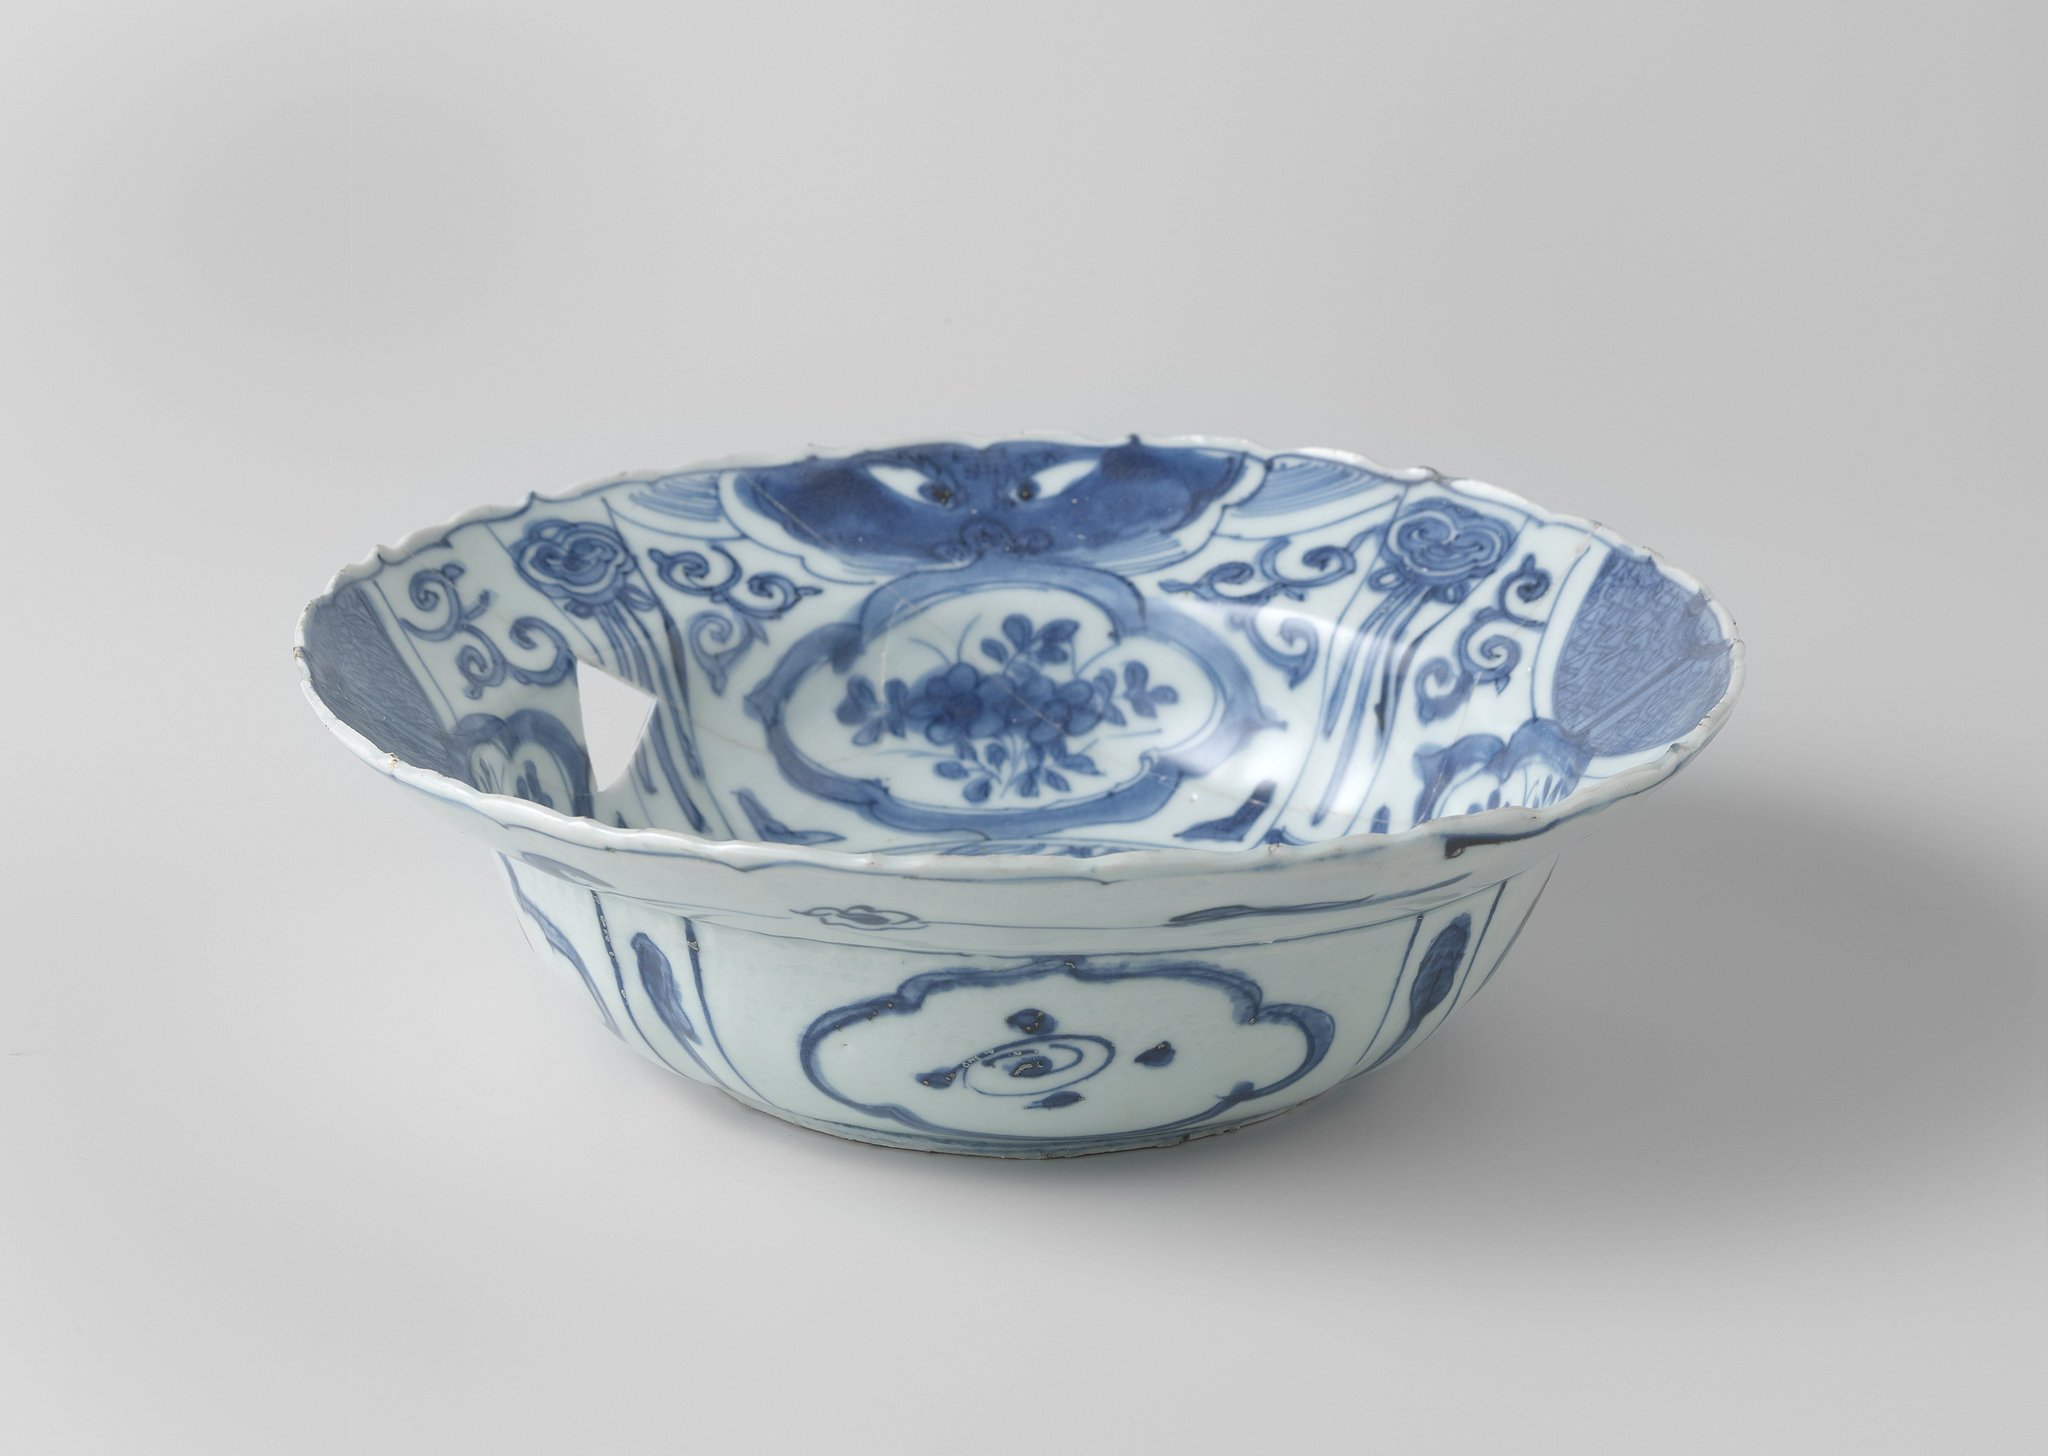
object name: plate dish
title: Bord uit V.O.C.-schip de 'Witte Leeuw'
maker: Anonymous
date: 1613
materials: bone china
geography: jingdezhen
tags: verenigde oostindische compagnie, sint-helena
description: Bord uit V.O.C.-schip de 'Witte Leeuw', 99% aanwezig; één scherf uit de wand ontbreekt. De scherf is glasachtig wit en kent weinig ingebakken vuil. Het glazuur is blauw getint. De bodem is geglazuurd en de voetring is gefacetteerd en staat naar binnen. Er is weinig ovenzand aangetroffen.